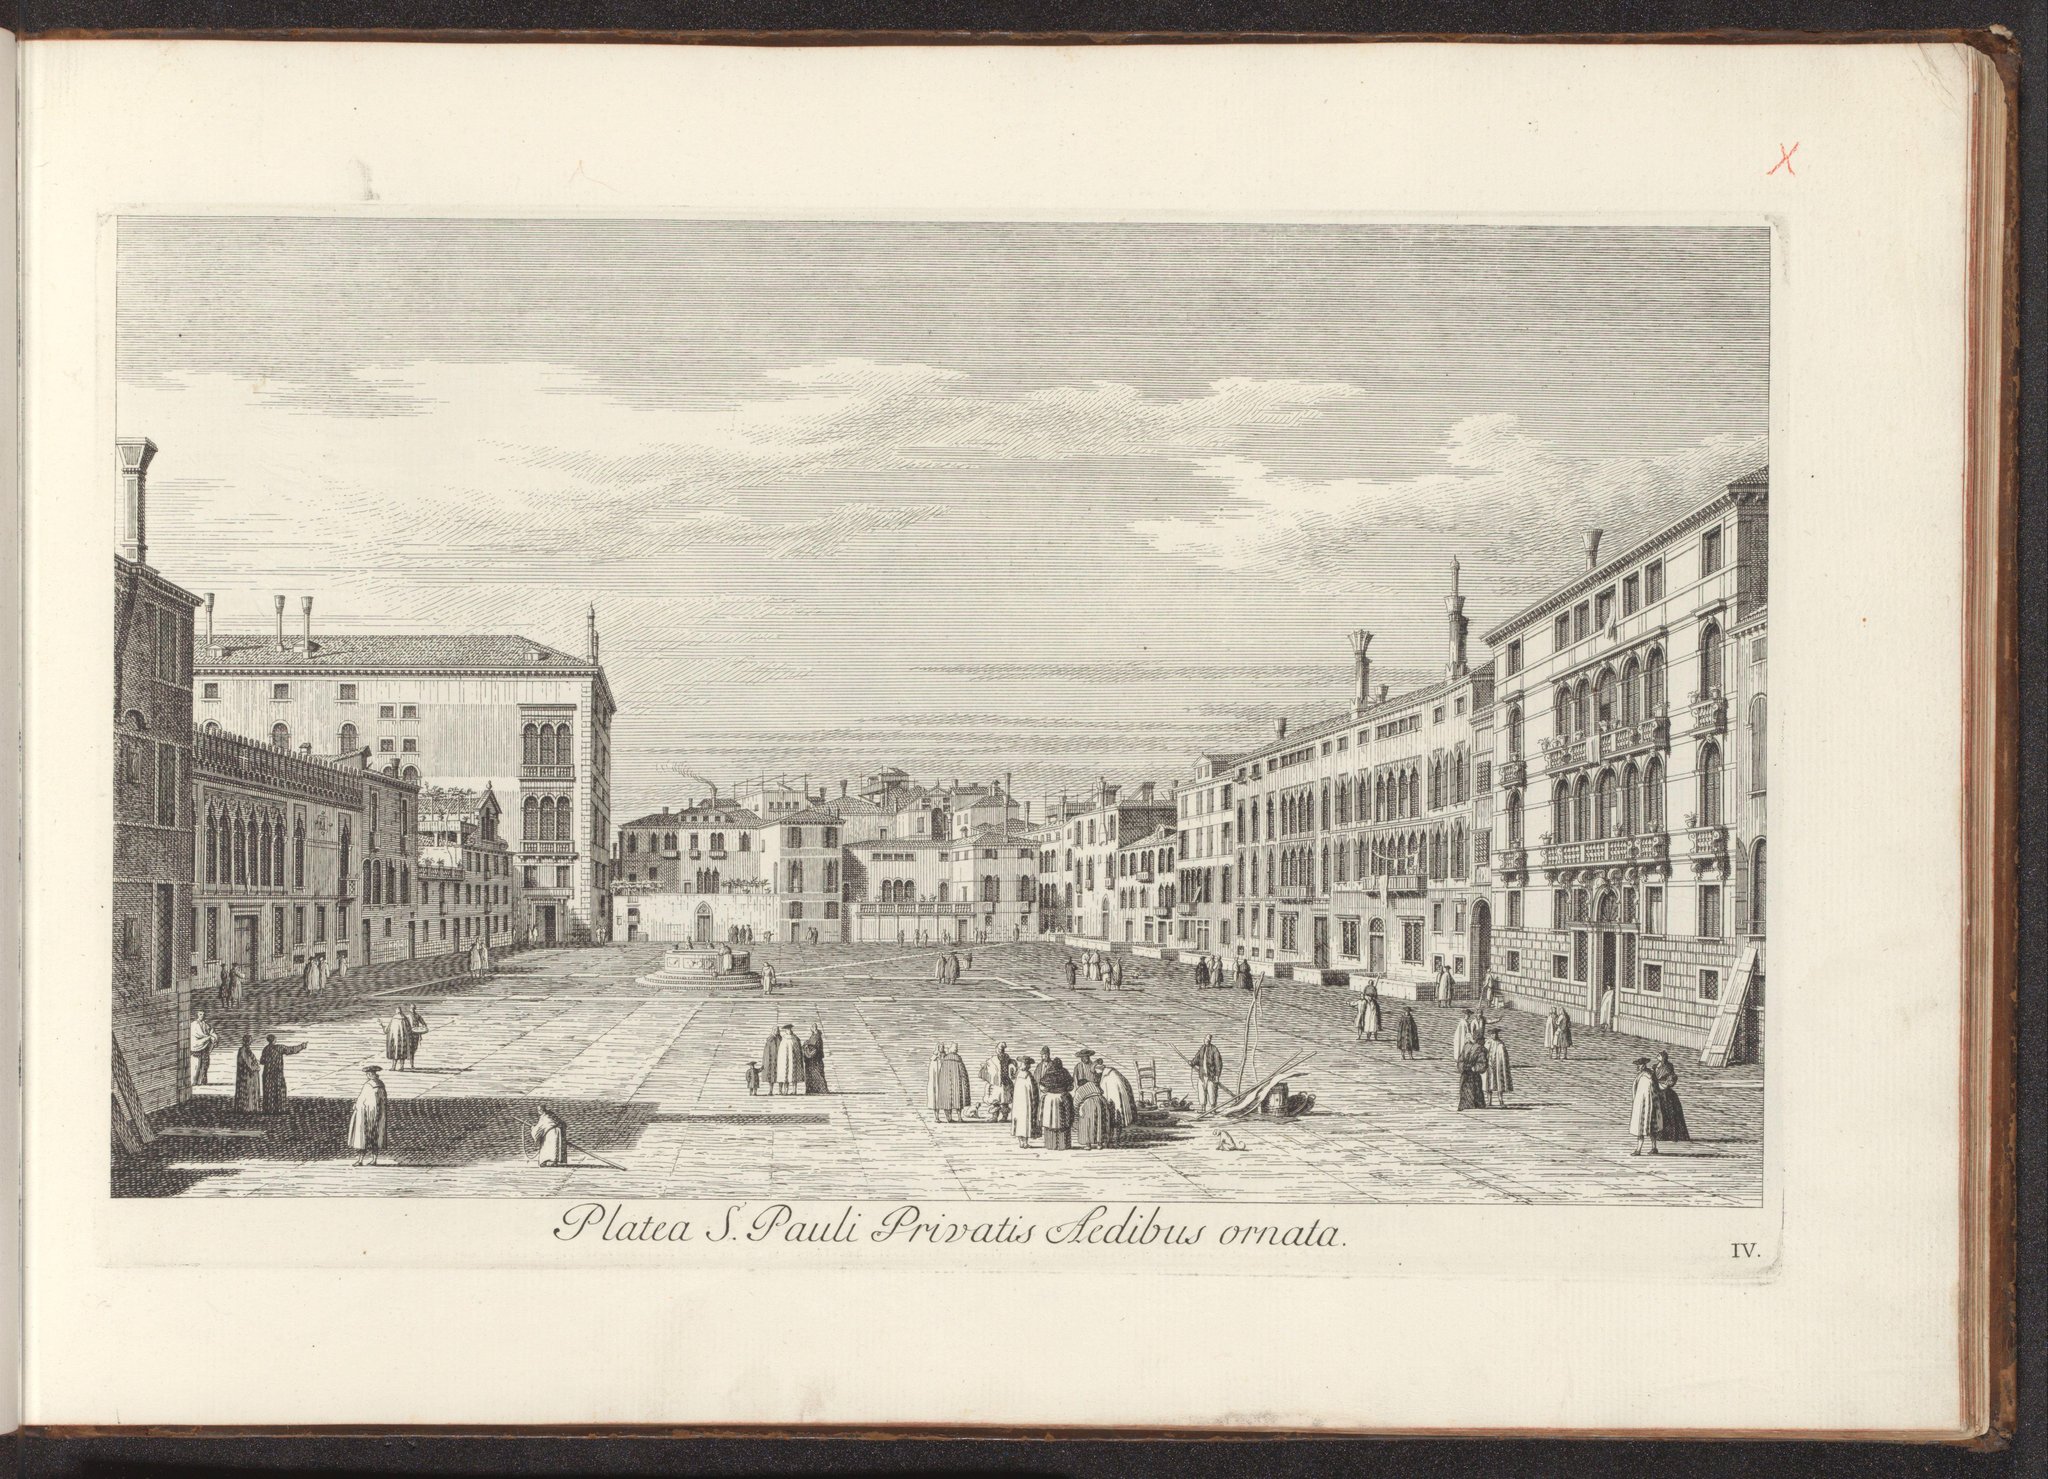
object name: album leaf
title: Urbis Venetiarum prospectus celebriores, ex Antonii Canal tabulis XXXVIII aere expressi ab Antonio Vissentini in partes tres distributi. pars tertia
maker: antonio visentini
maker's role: draughtsman, print maker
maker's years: 1688-1782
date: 1742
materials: paper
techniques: etching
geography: venice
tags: square, place, circus, etc., city-view, and landscape with man-made constructions, canal